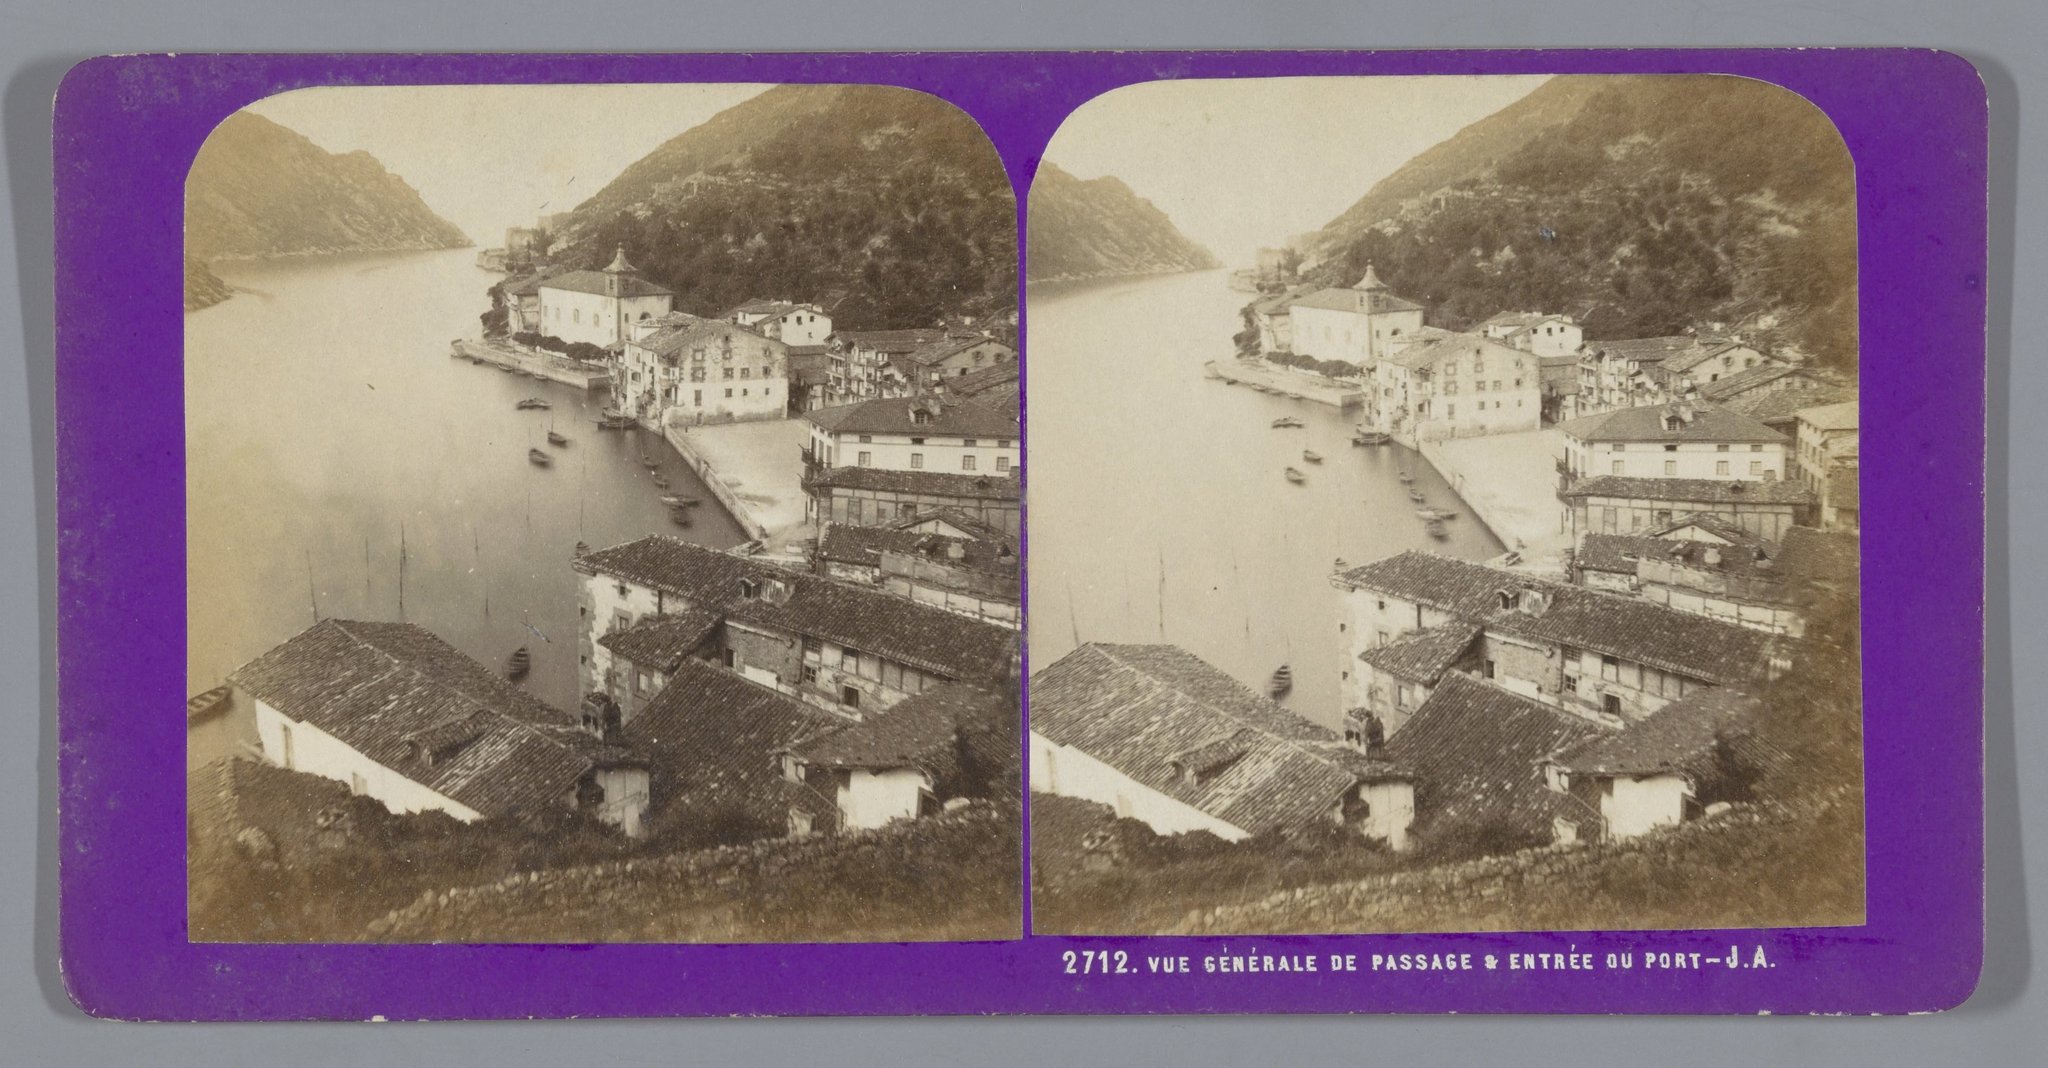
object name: stereograph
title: VUE GÉNÉRALE DE PASSAGE & ENTRÉE OU PORT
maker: jean andrieu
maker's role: fotograaf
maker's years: 1816-1872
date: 1862-1876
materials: cardboard, photographic support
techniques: albumen print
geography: spain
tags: prospect of city, town panorama, silhouette of city, sea, spain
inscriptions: number: ‘2712.’